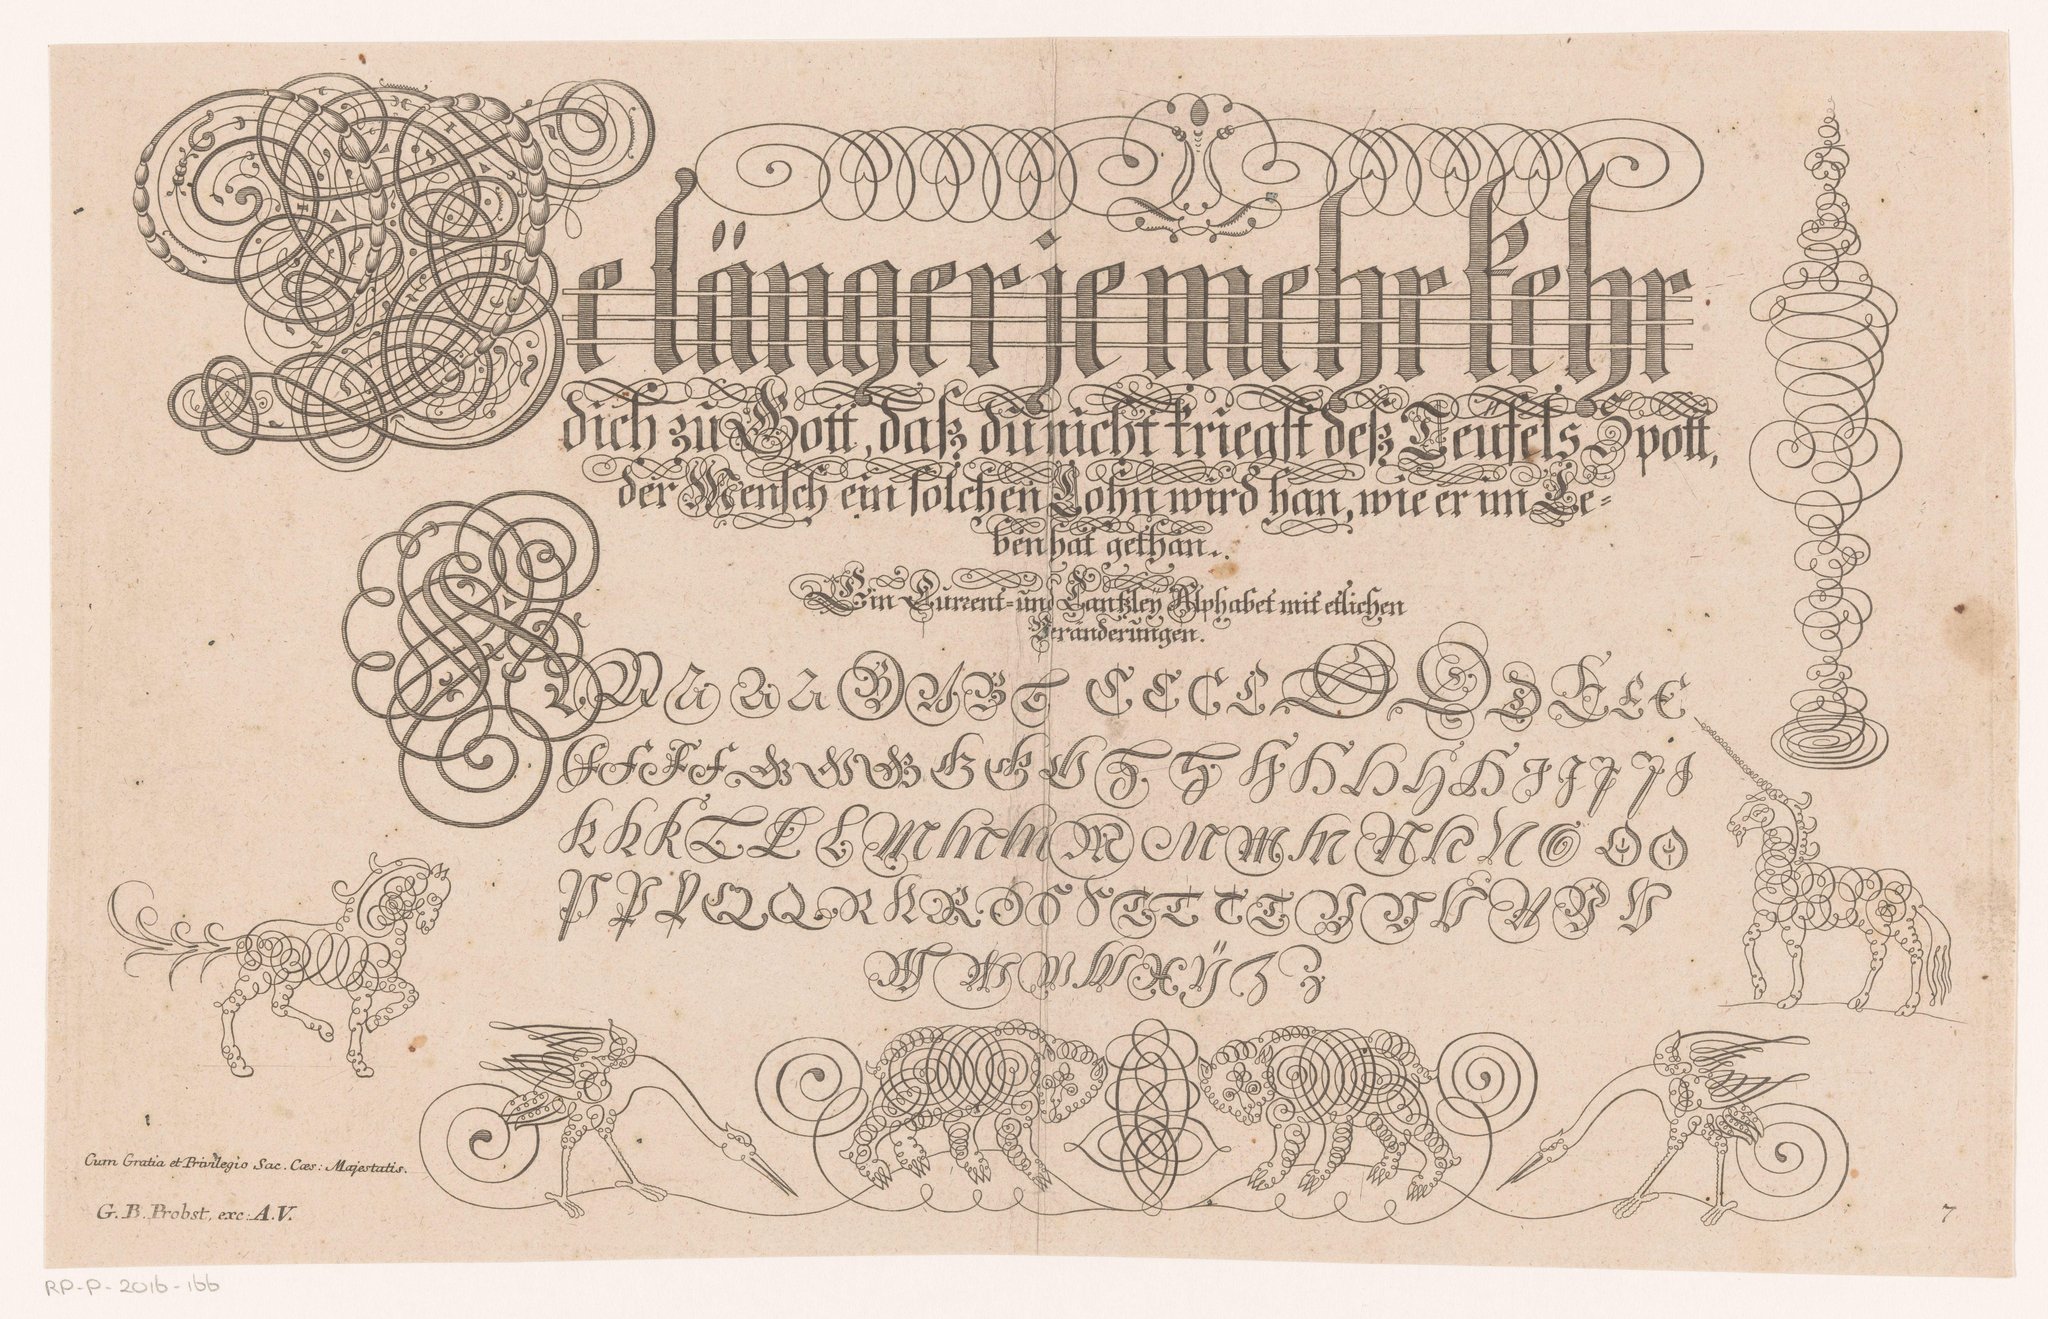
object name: print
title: Kalligrafie en dieren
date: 1766-1790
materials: paper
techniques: engraving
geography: stuttgart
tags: animals, calligraphy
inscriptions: collector's mark: Lugt 2228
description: Gekalligrafeerd alfabet en gekalligrafeerde tekst: Je länger je mehr kehr dich zu Gott (...) Aan de onderzijde diverse dieren in stijl van de kalligrafie.